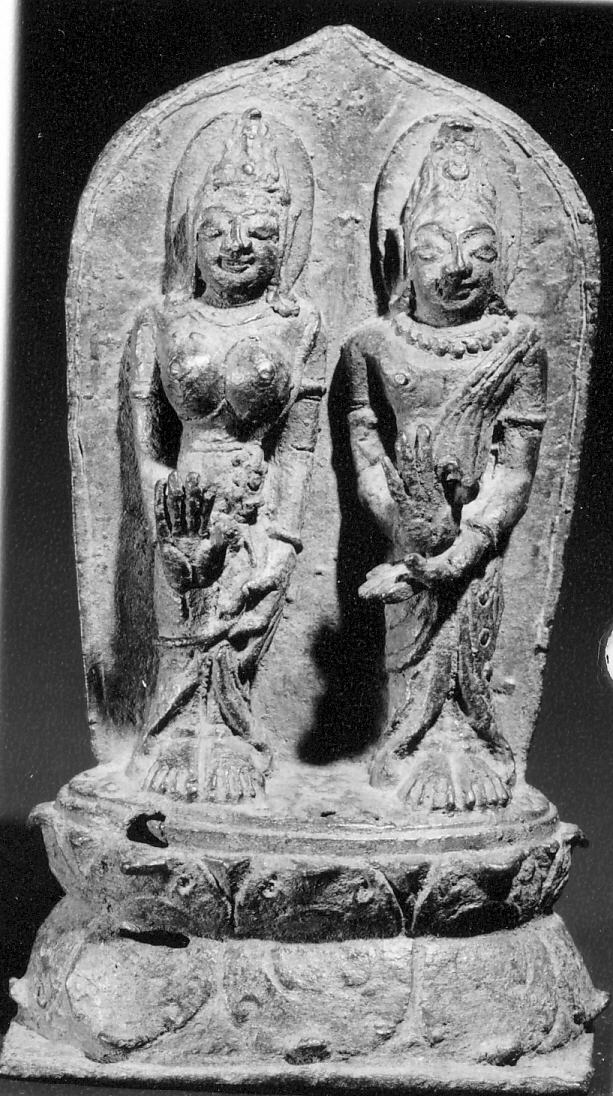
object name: figure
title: Ancestral Pair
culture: indonesian, javanese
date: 1301-1500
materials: bronze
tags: couples